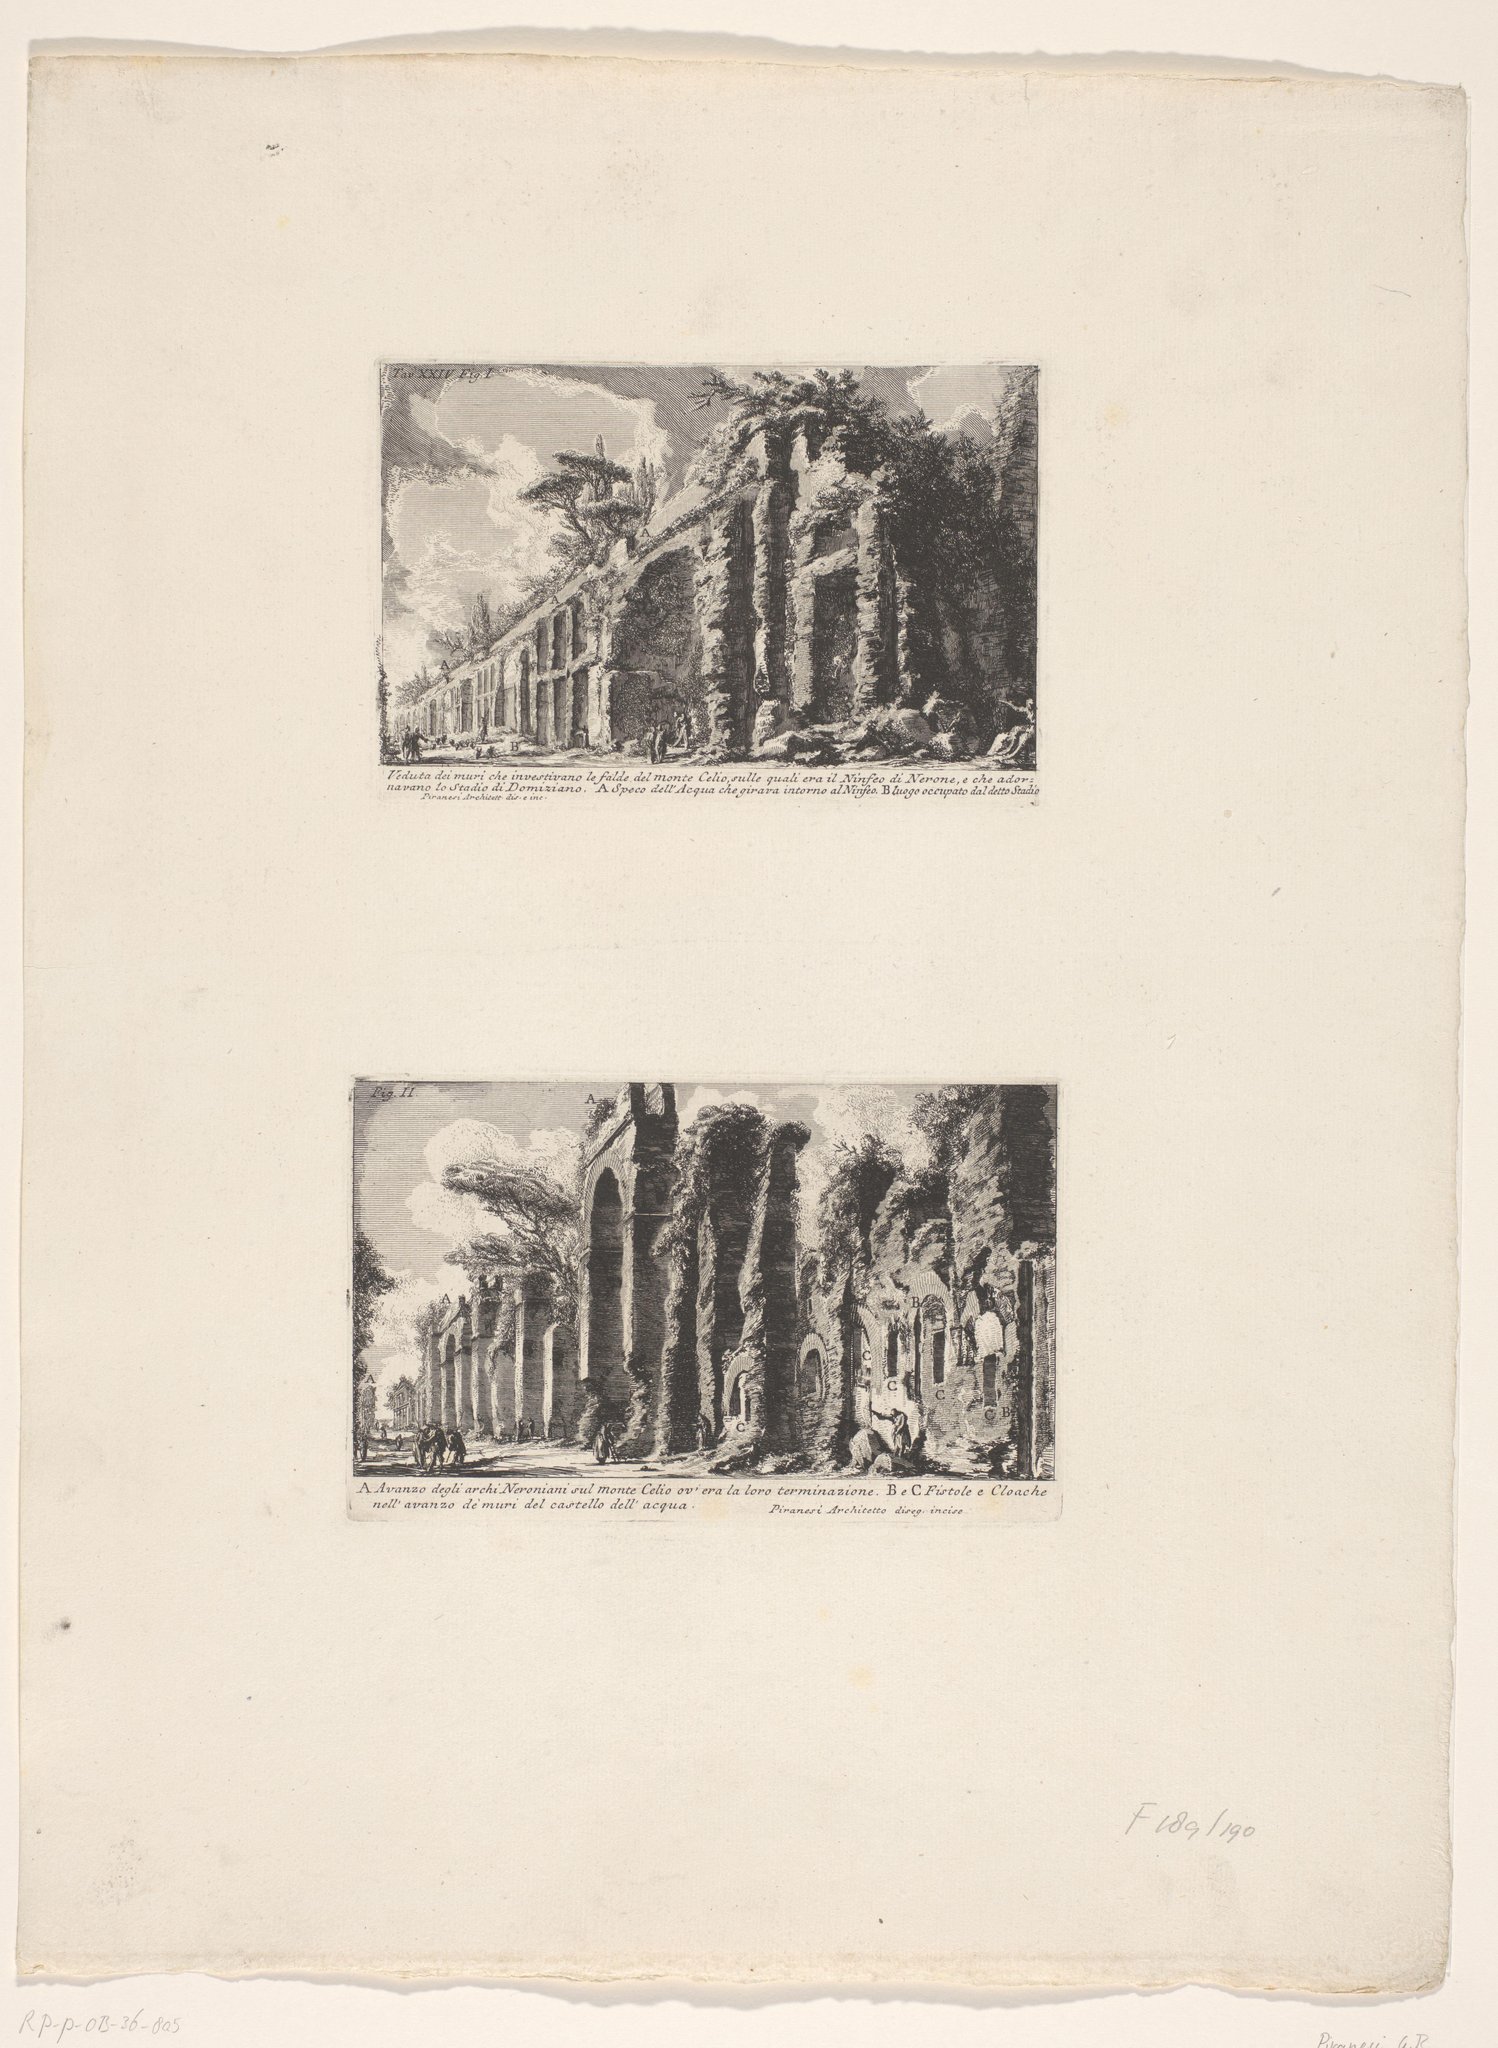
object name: print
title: Muren rondom de Coelius en restanten van de Arcus Neroniani te Rome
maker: giovanni battista piranesi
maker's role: designer, draughtsman, print maker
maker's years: 1720-1778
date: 1756-1757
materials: paper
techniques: etching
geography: rome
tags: ruin of a building ~ architecture, aqueduct (~ water supply)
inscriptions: collector's mark: Lugt 2228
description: Blad met twee voorstellingen van Romeinse bouwwerken. Boven: ruïneuze muren rondom de heuvel Coelius. Genummerd linksboven: Tav. XXIV Fig. I. titel en verklarende lijst met letters in ondermarge. Onder: restanten van het einde van de Arcus Neroniani, een aftakking van het aquaduct Aqua Claudia. Genummerd linksboven: Fig. II. Verklarende lijst met letters in ondermarge.